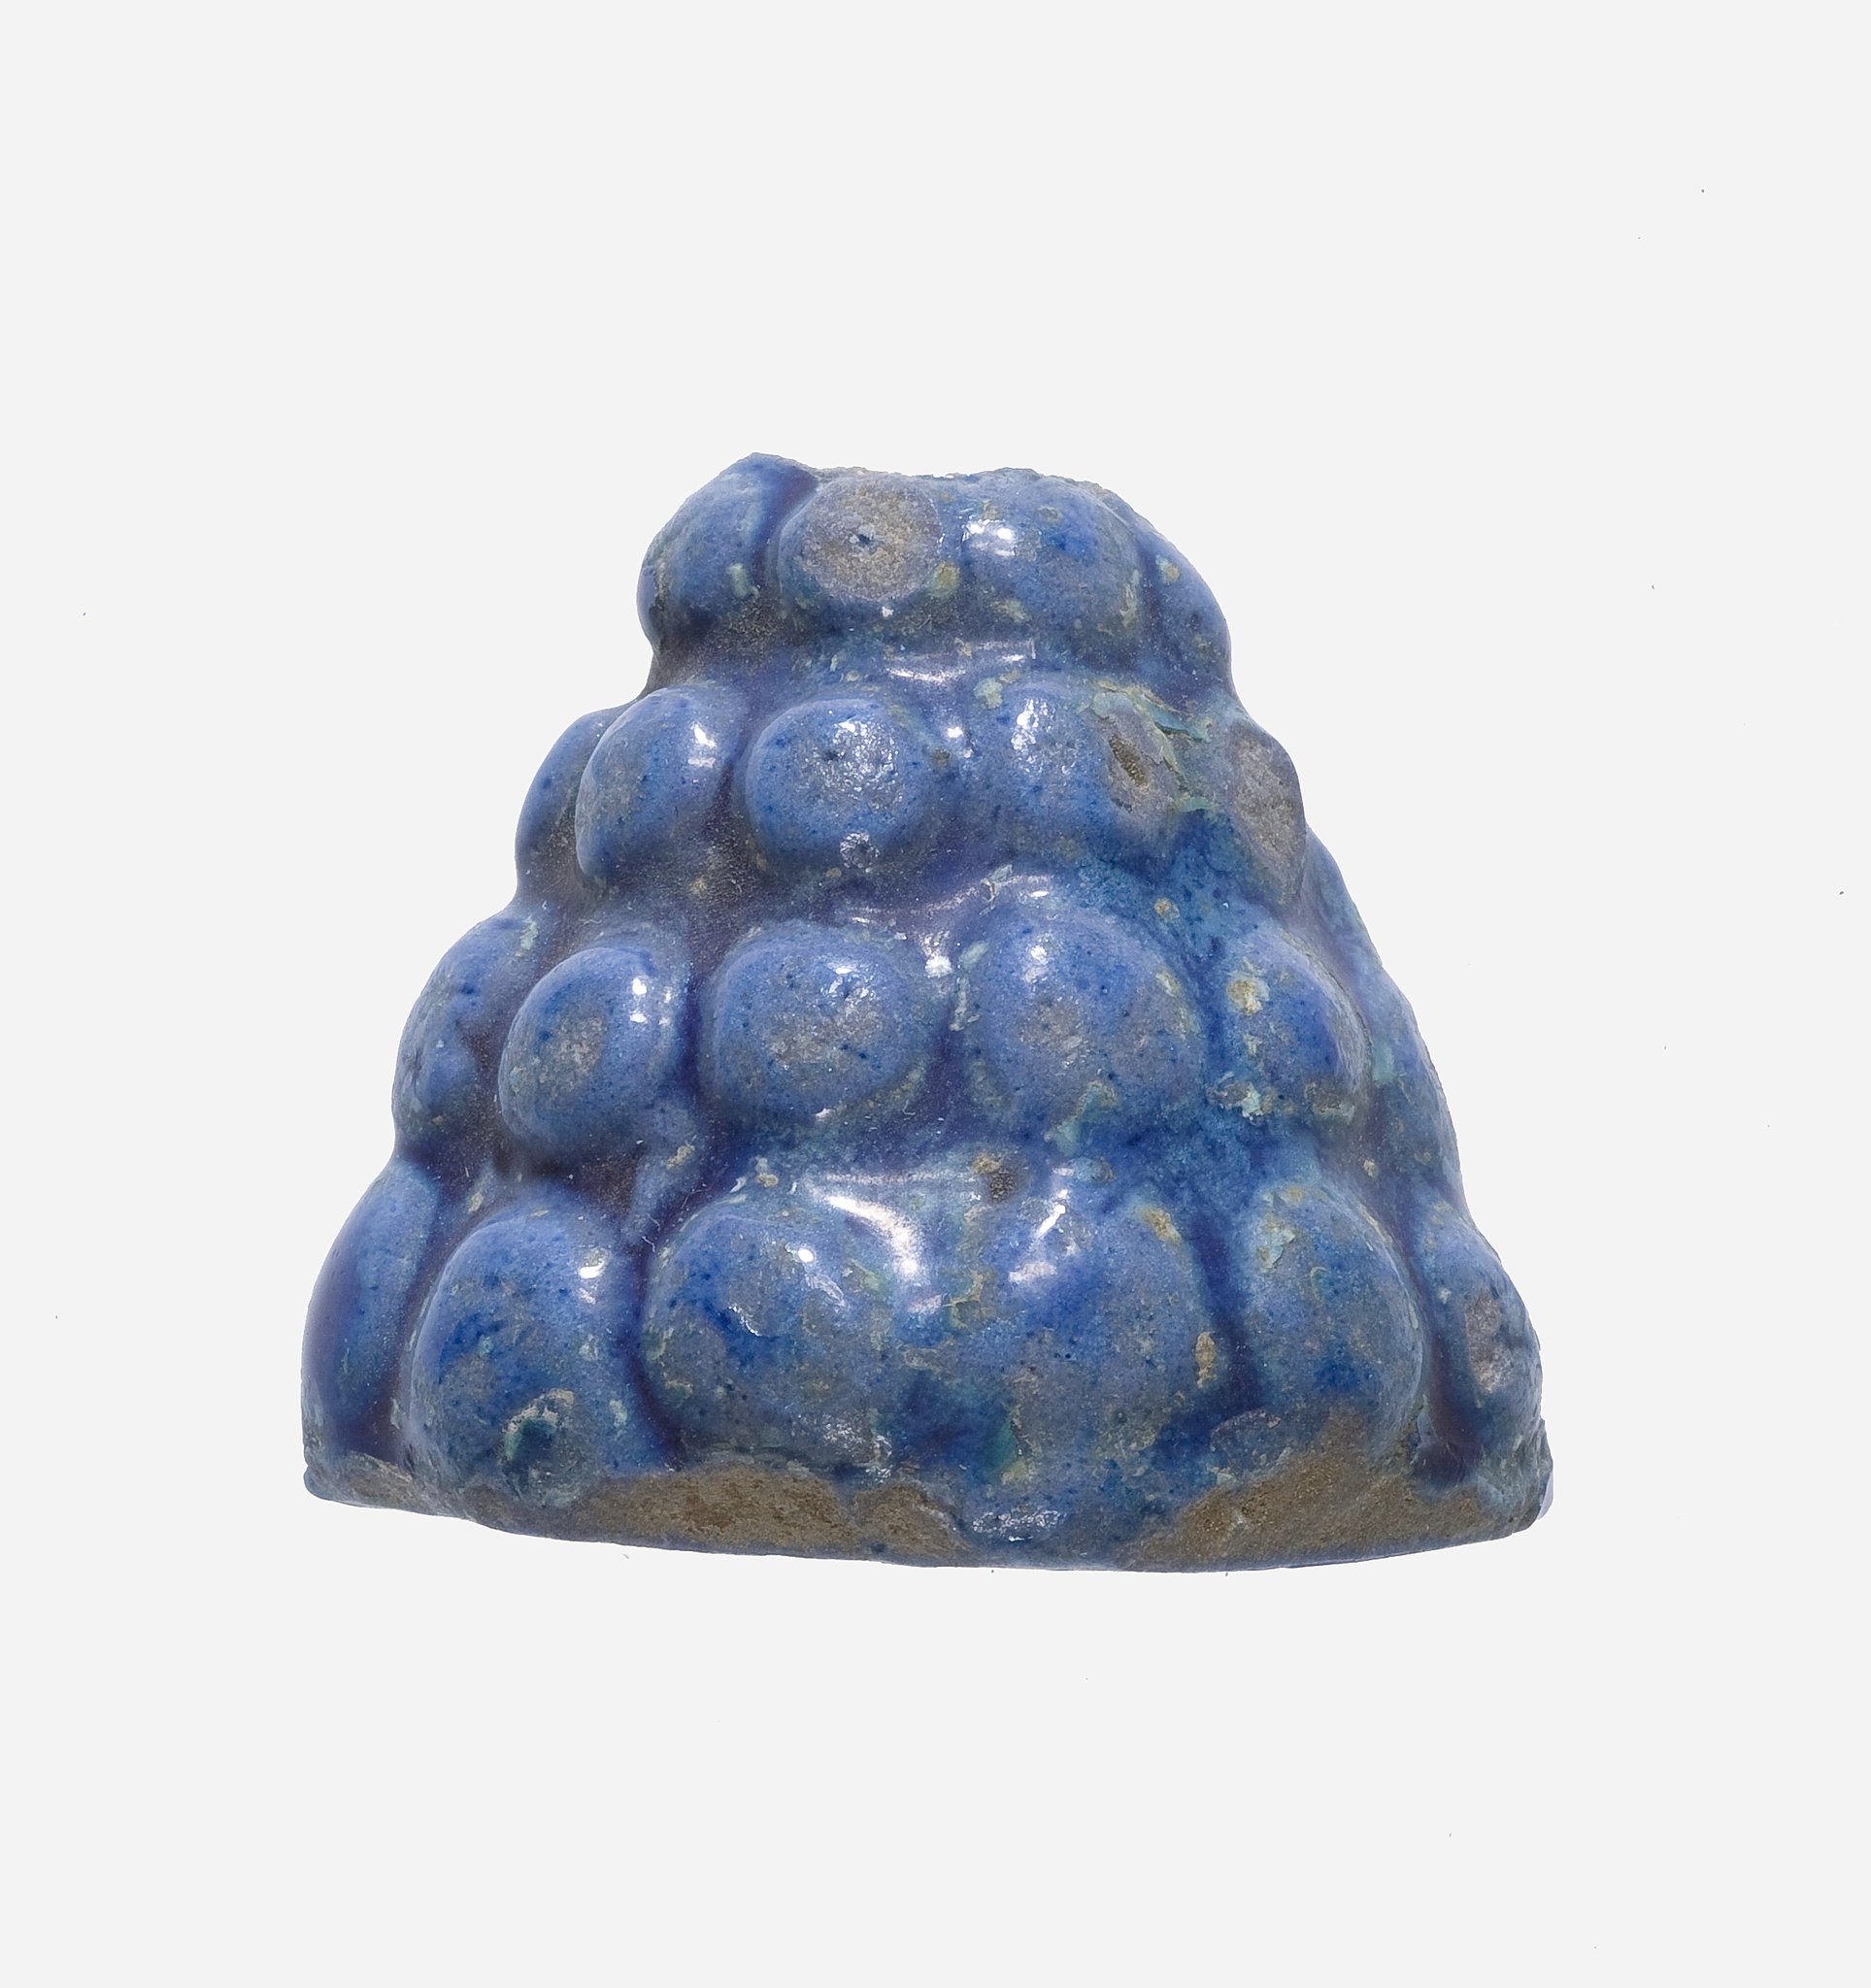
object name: ornament, grape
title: Architectural Ornament: Bunch of Grapes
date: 1390-1352 BCE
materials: faience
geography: egypt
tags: grapes